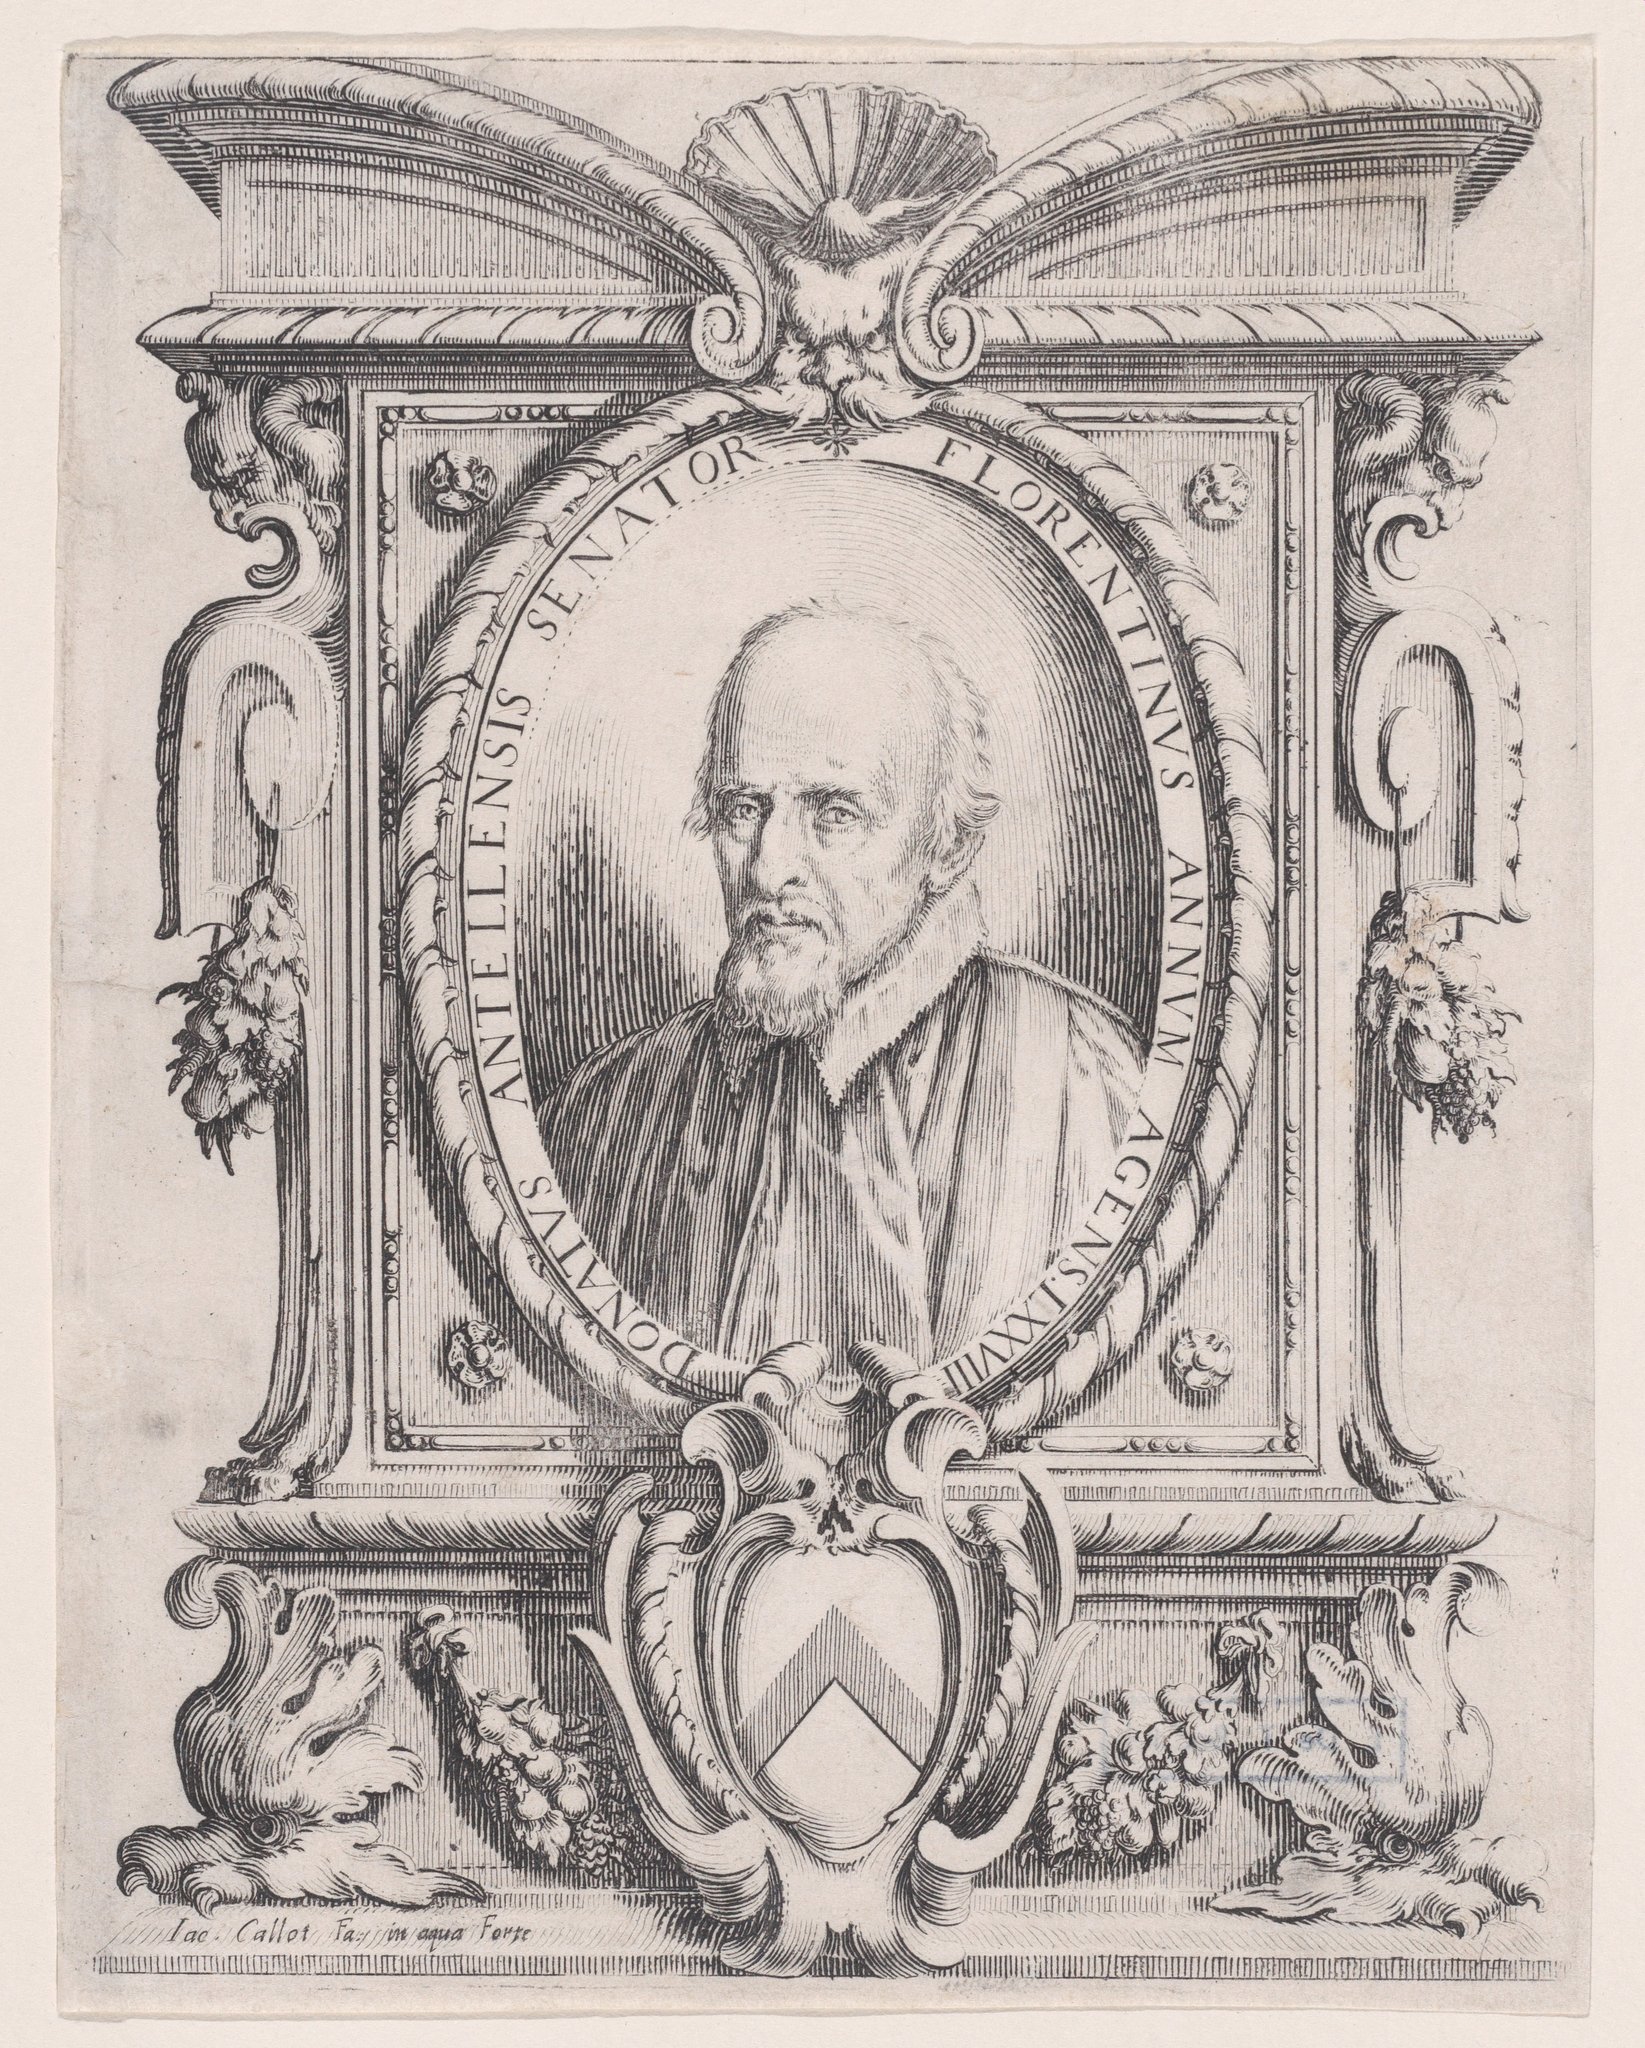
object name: print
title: Portrait du Sénateur Donato dell'Antella (Portrait of Senator Donato dell'Antella)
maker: jacques callot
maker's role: artist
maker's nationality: french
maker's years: 1592-1635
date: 1618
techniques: etching